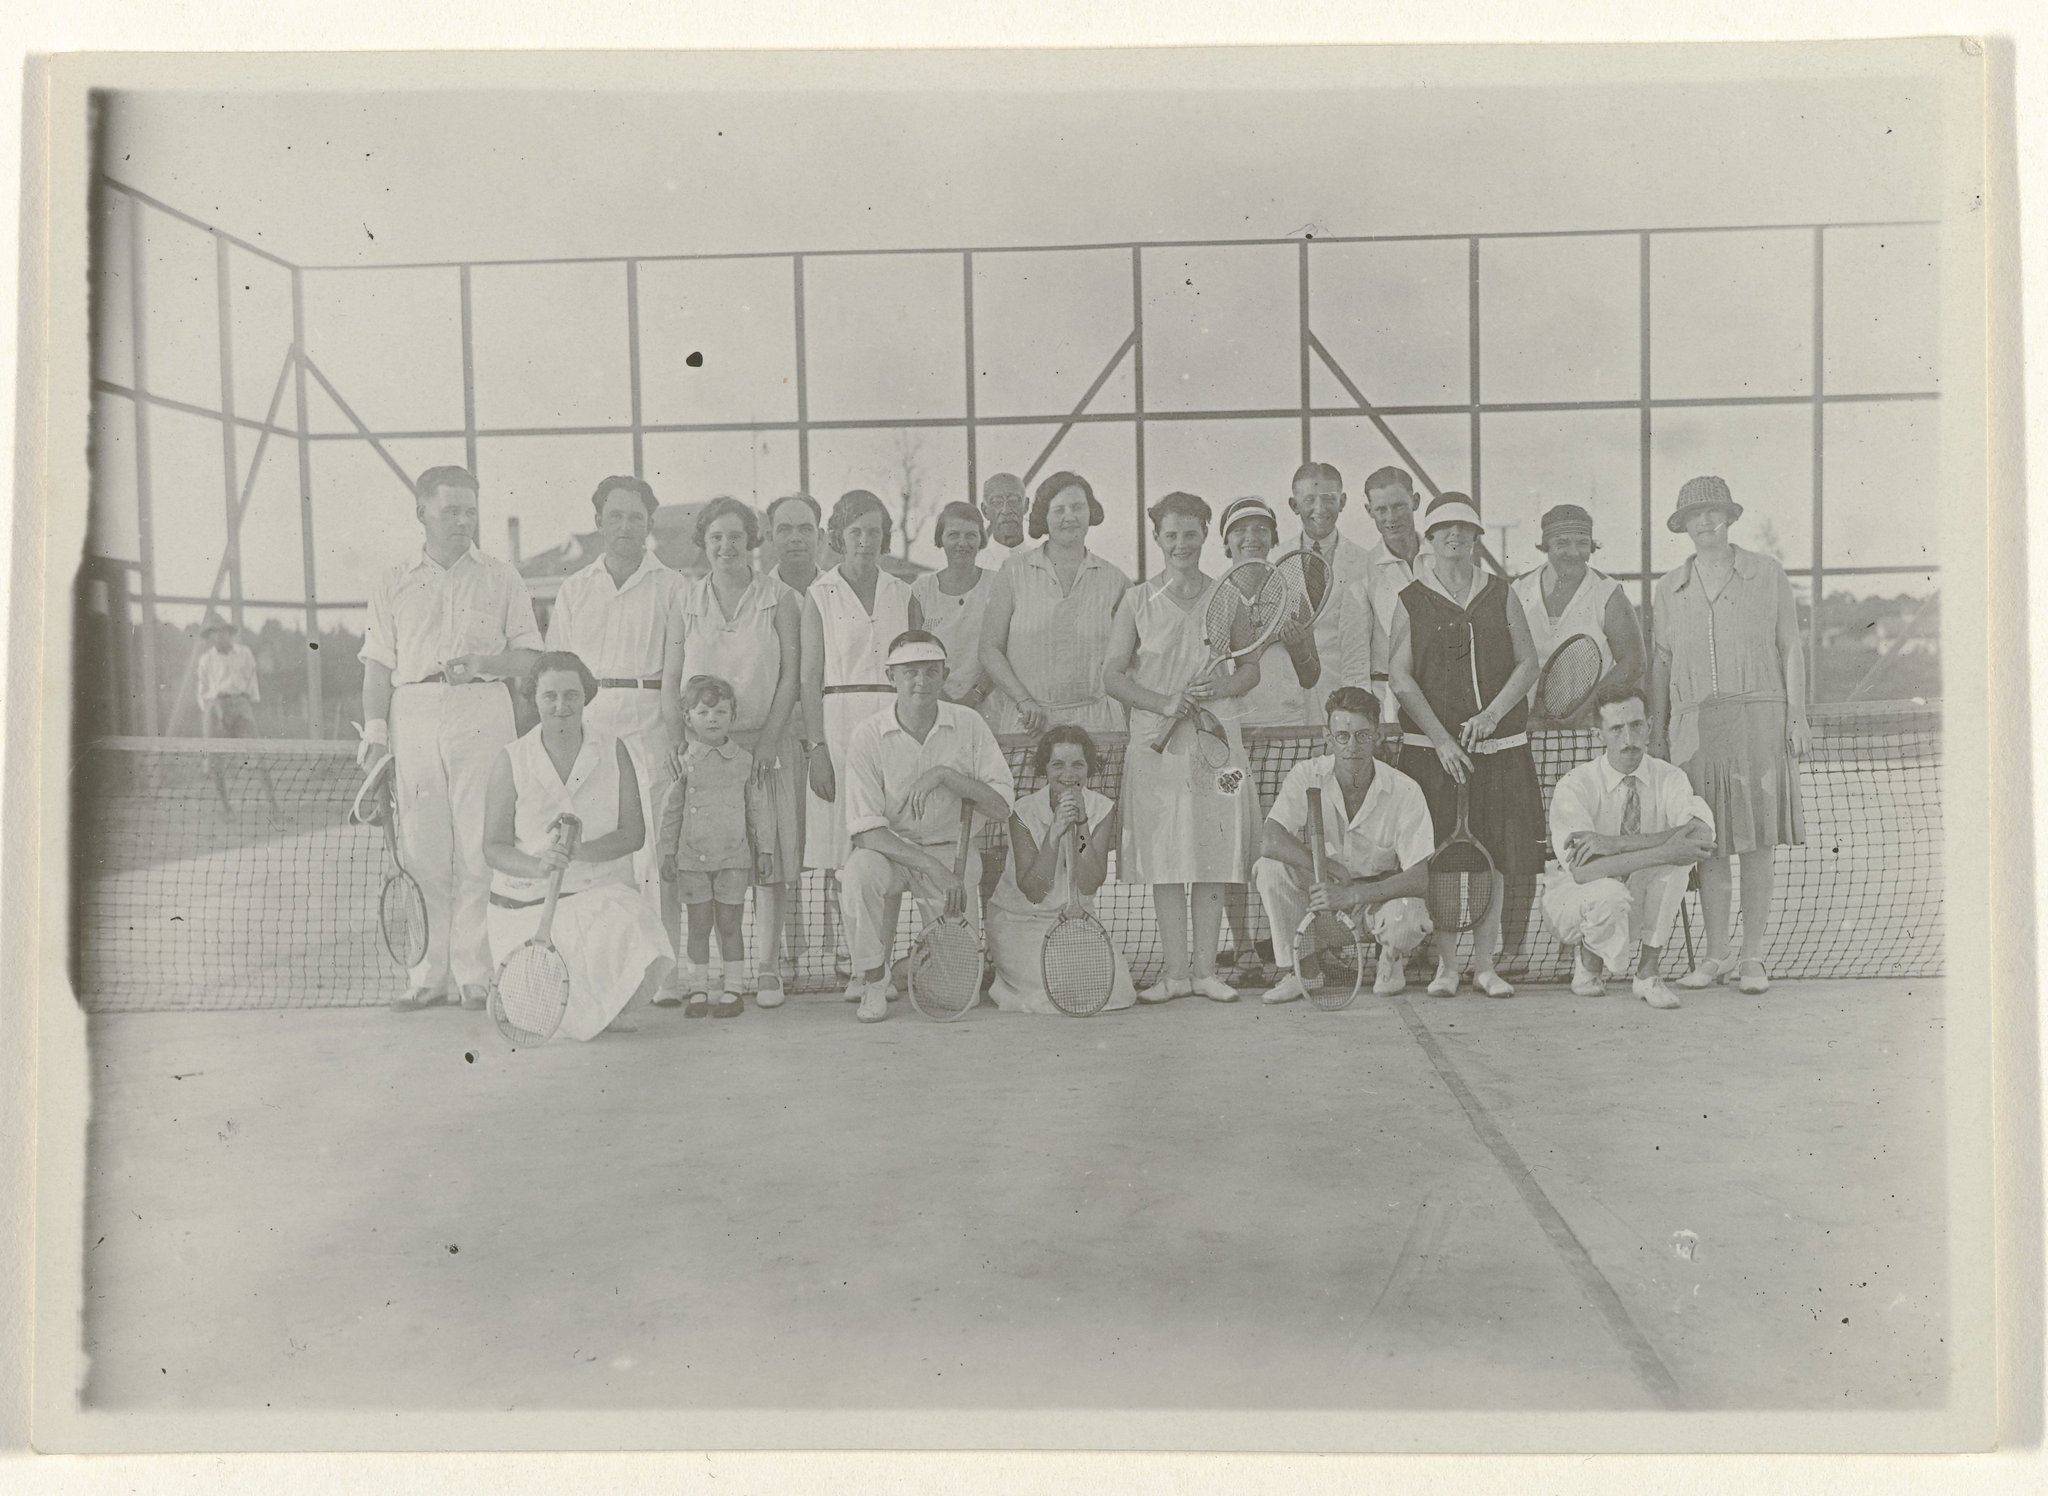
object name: photograph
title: Gezelschap op tennisbaan in Moengo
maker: Anonymous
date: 1930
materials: photographic support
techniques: photography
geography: suriname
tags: tennis, lawn-tennis